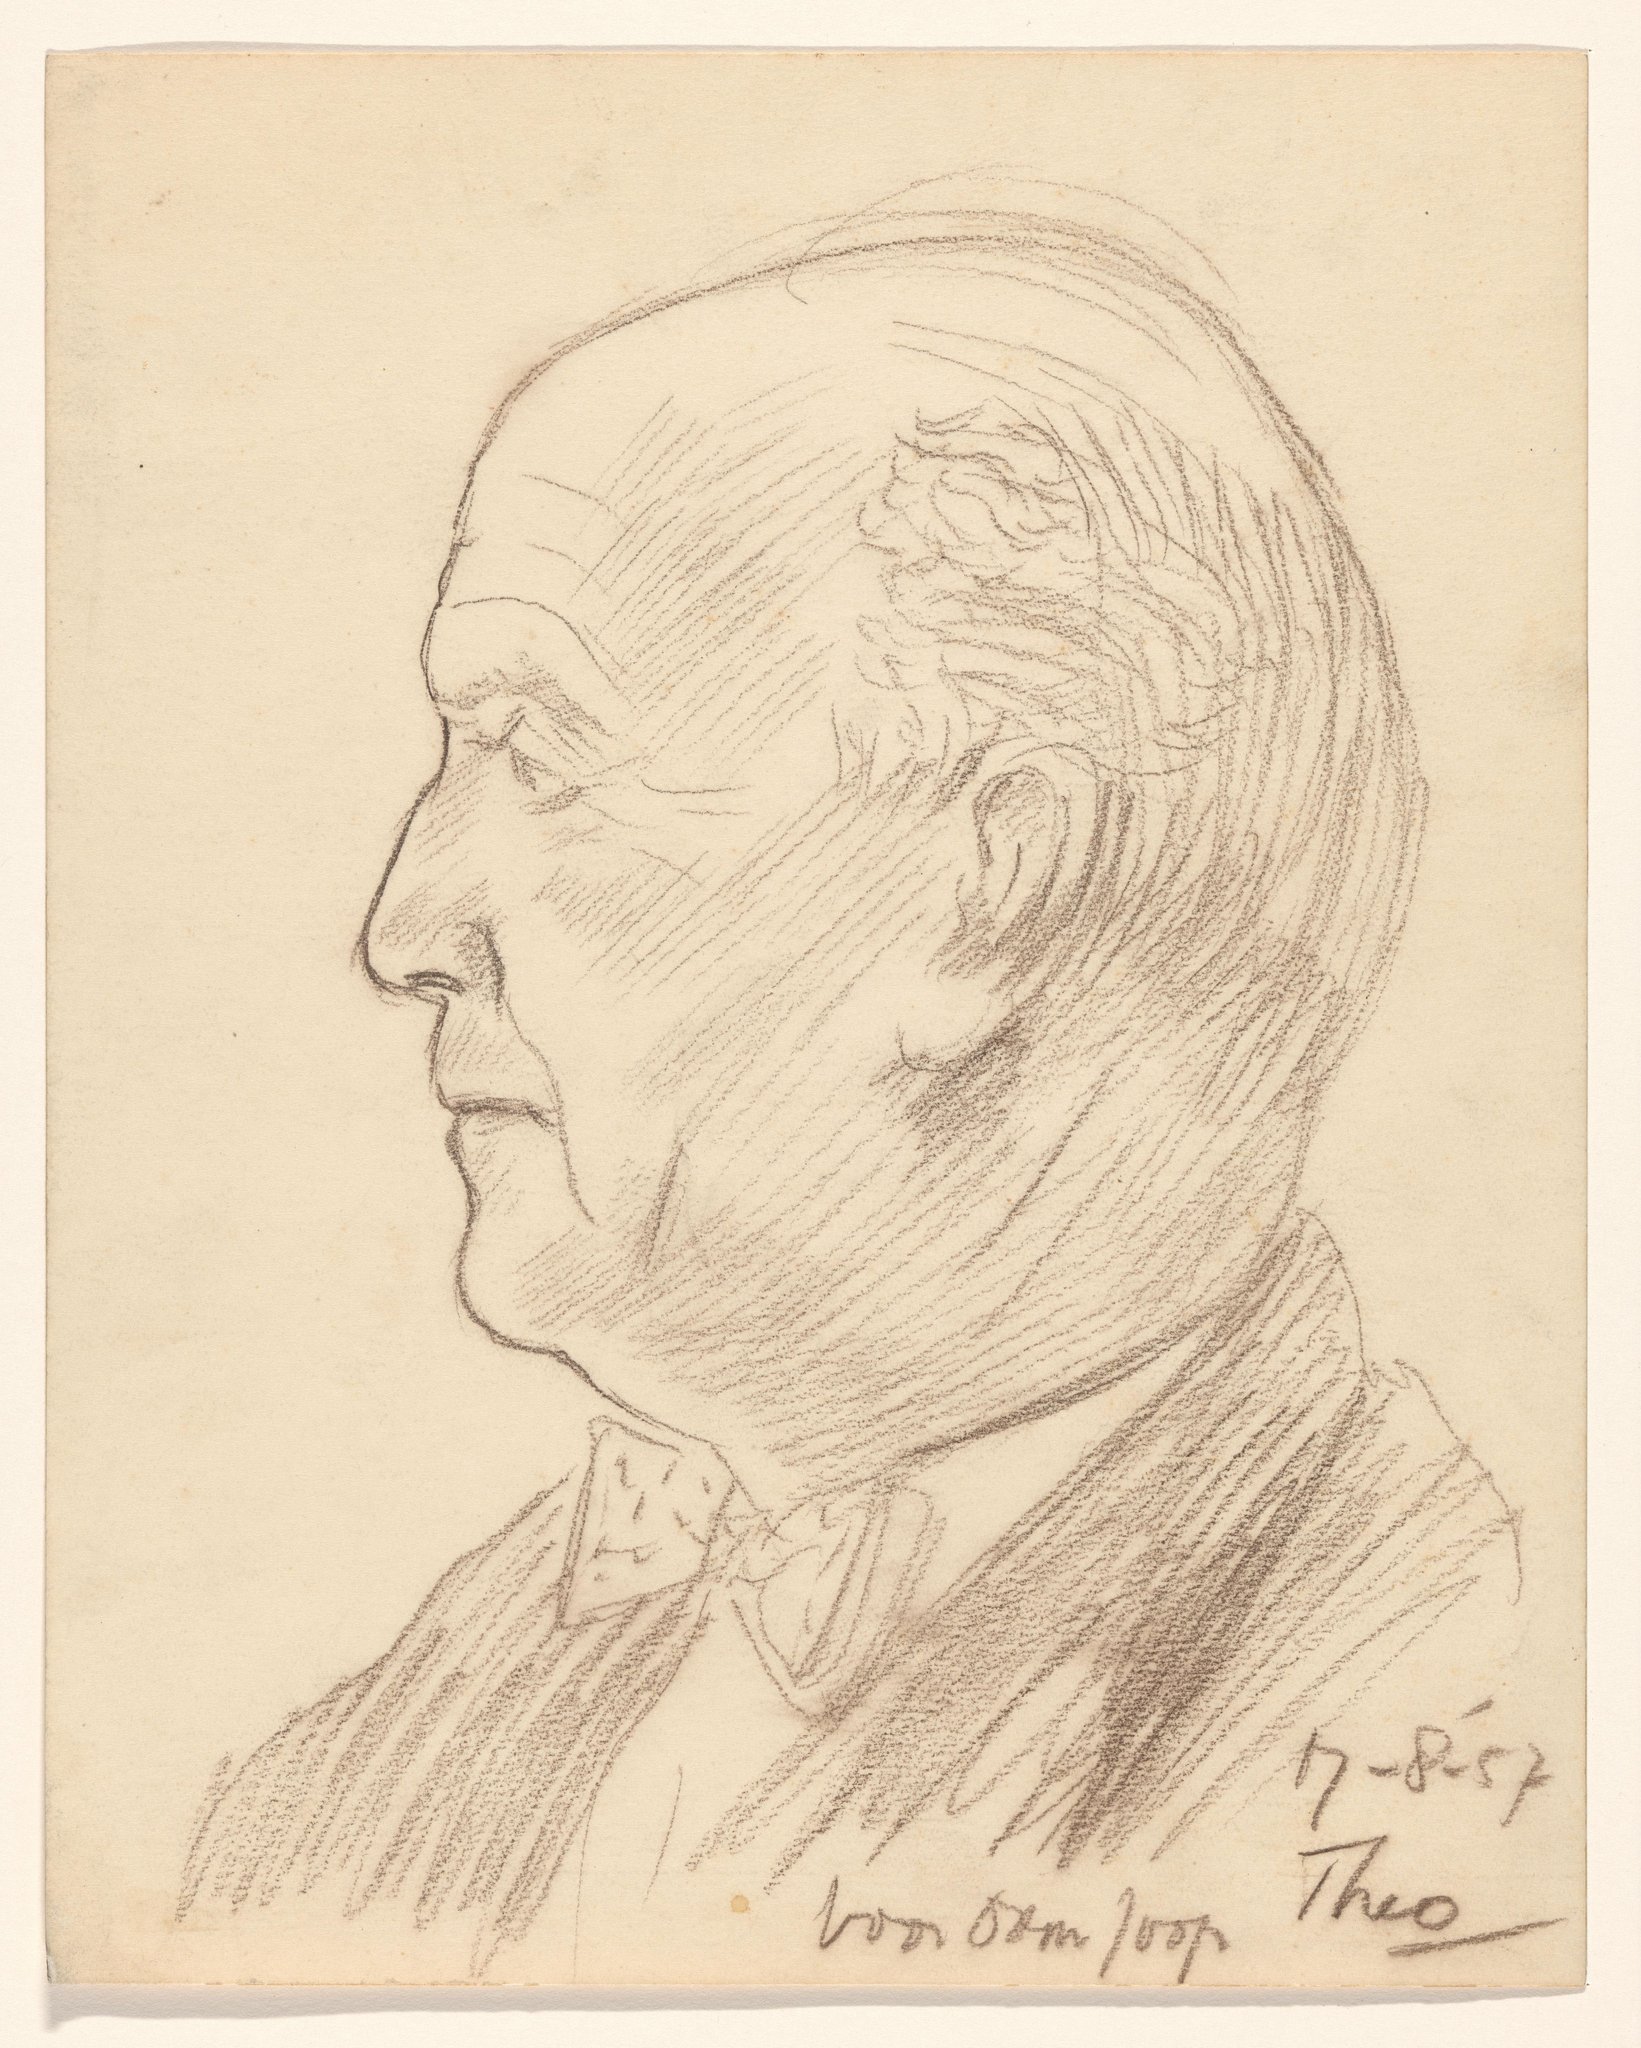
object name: drawing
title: Portret van Oom Joop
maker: Anonymous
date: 1957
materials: chalk, paper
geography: netherlands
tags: old man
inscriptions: inscription: ‘Voor Oom Joop / 17-8-'57 / Theo’